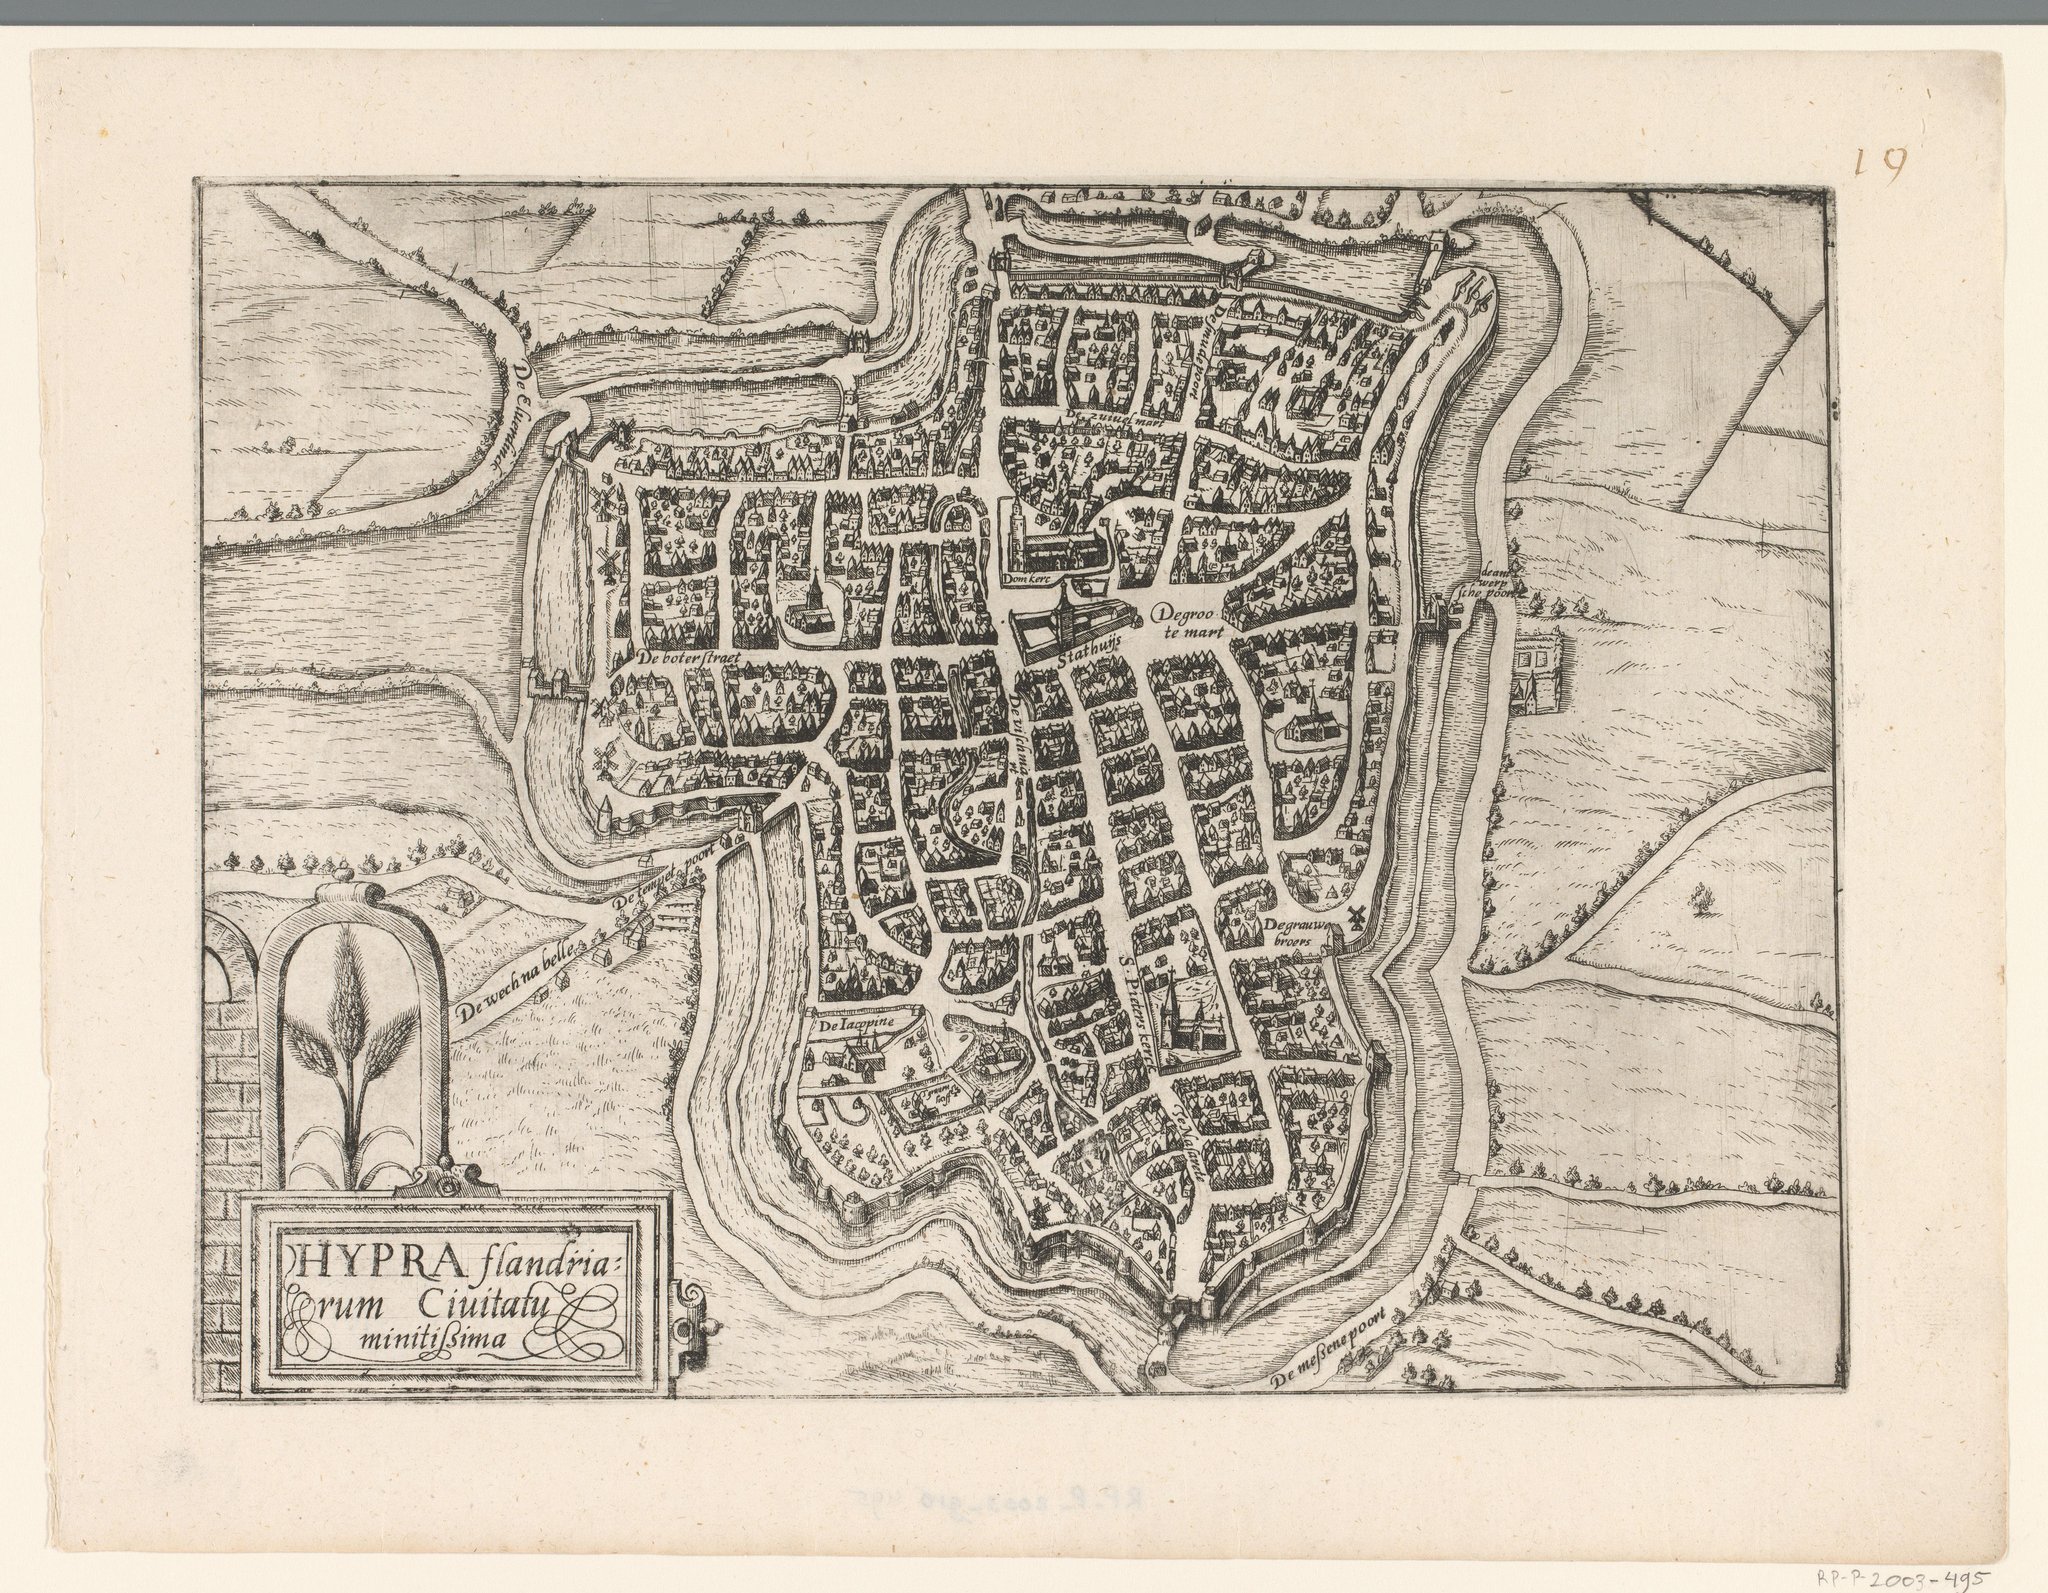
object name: print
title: Plattegrond van Ieper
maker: Anonymous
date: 1607-1609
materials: paper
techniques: etching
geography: southern netherlands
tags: maps of cities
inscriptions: number: ‘19’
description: Plattegrond van de stad Ieper. Linksonder een cartouche met de titel en een korenaar. Onderdeel van de verzameling kaarten genomen uit een latere editie van: Descrittione di tutti i Paesi Bassi van Lodovico Guicciardini.